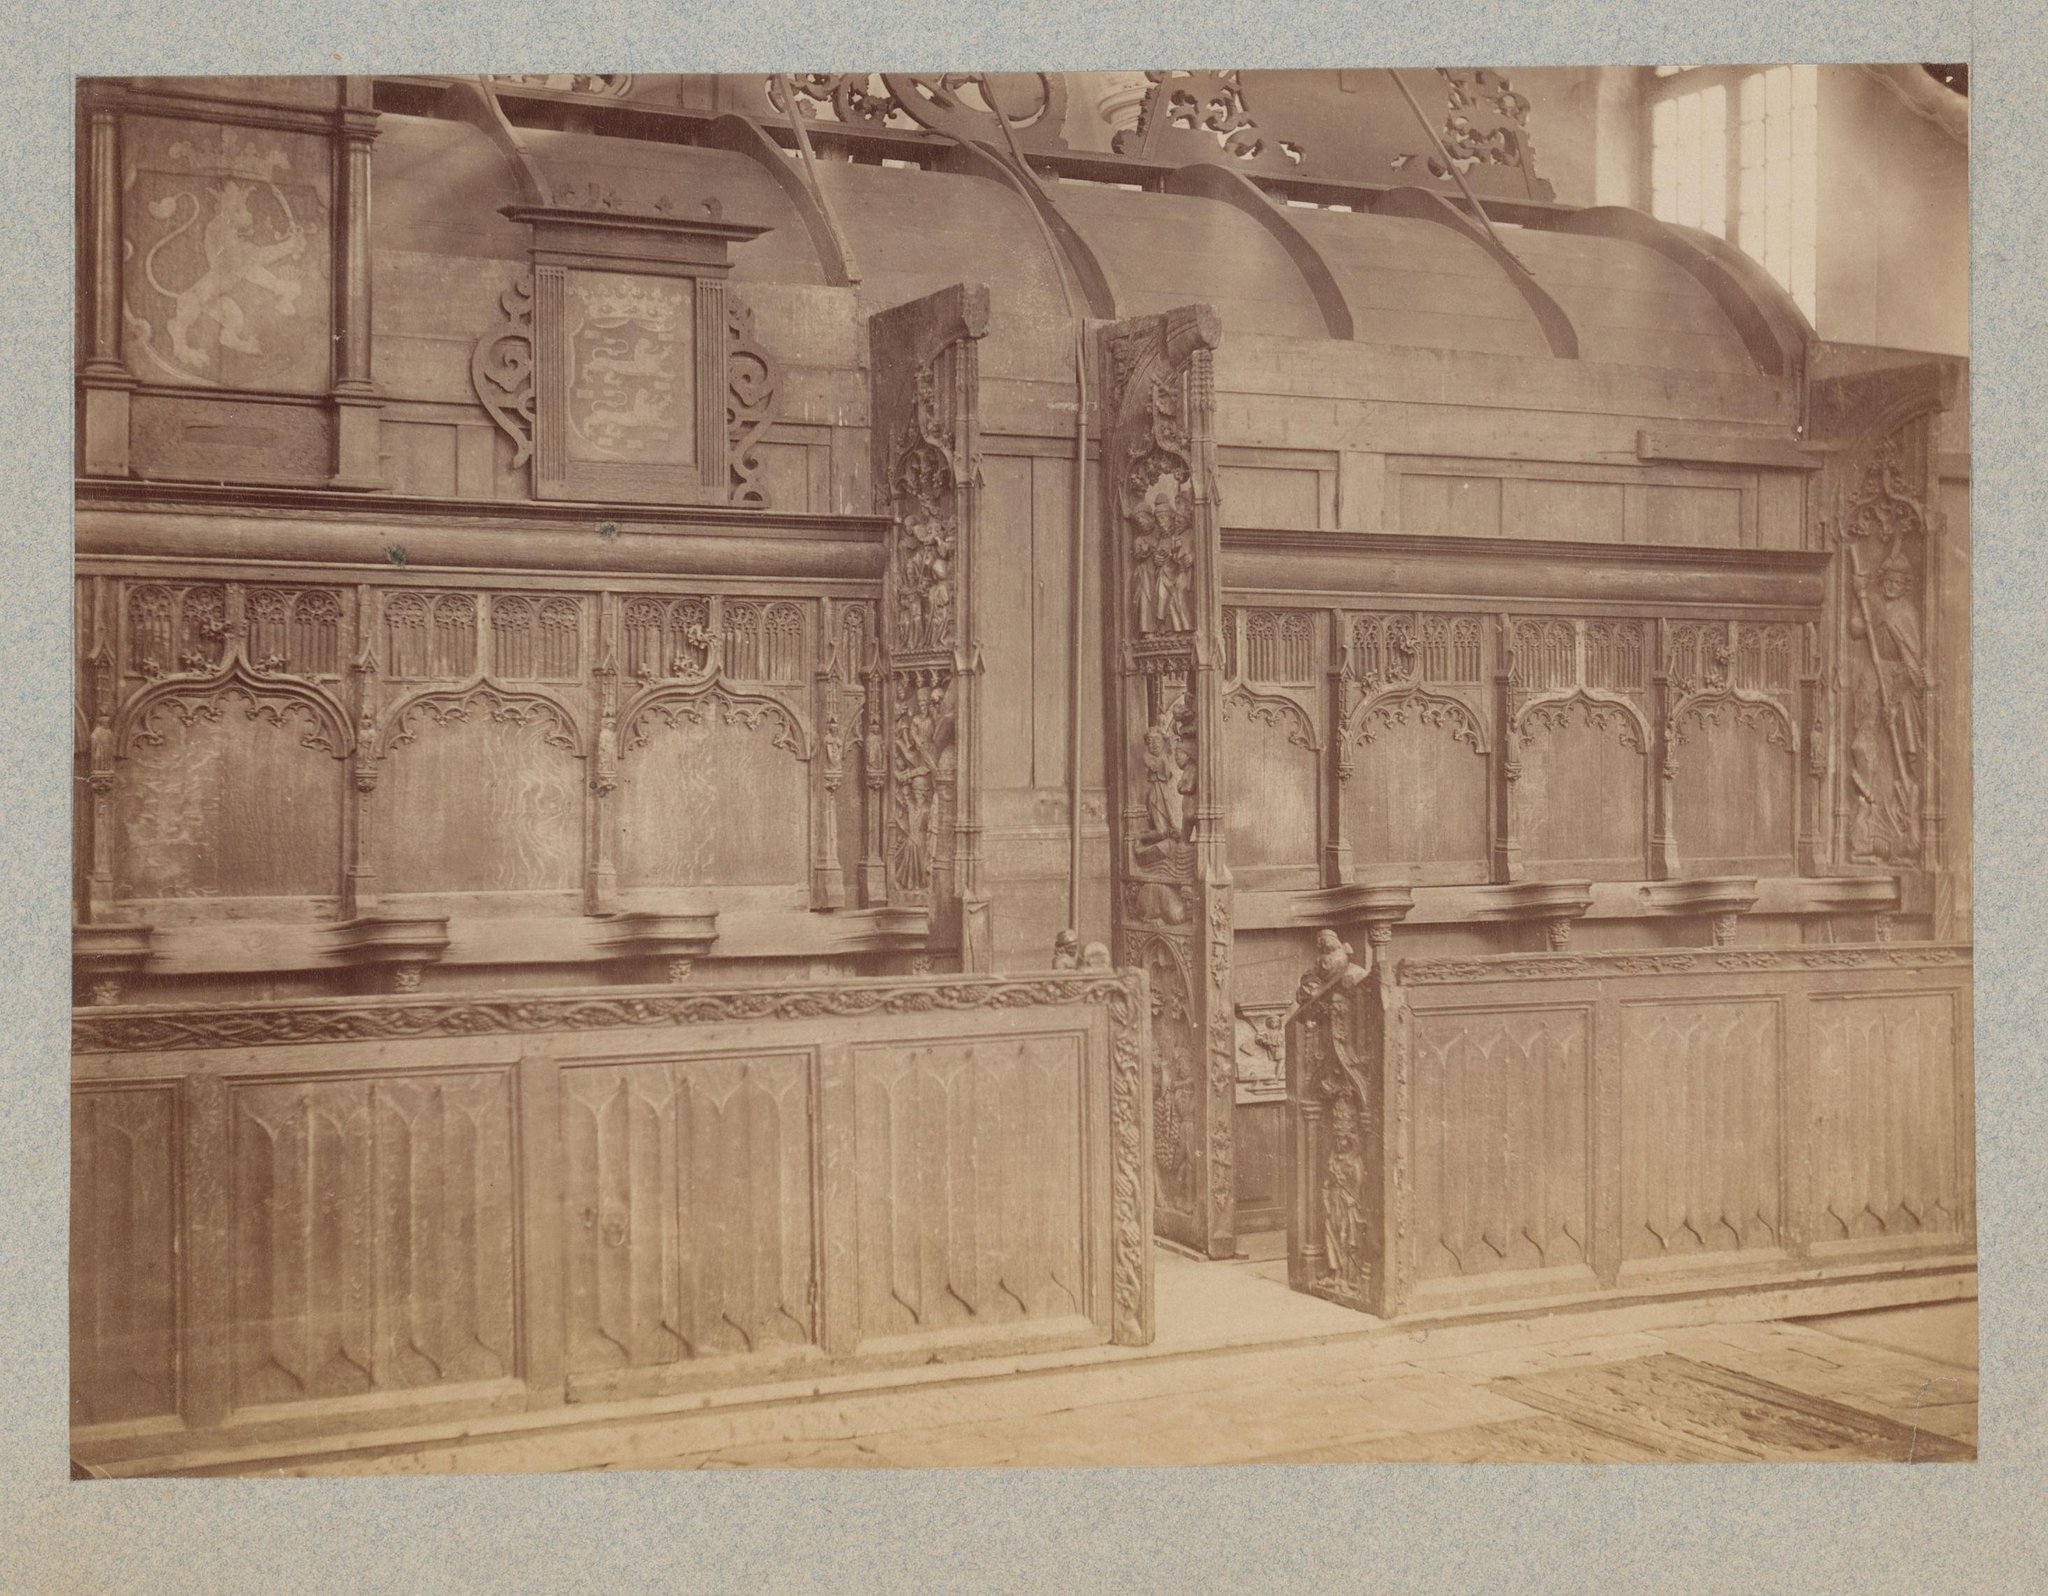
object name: photograph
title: Interieur van en kerk met koorbanken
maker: Anonymous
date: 1870-1900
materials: cardboard, photographic support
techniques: albumen print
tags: seats of the clergy, choir-stalls